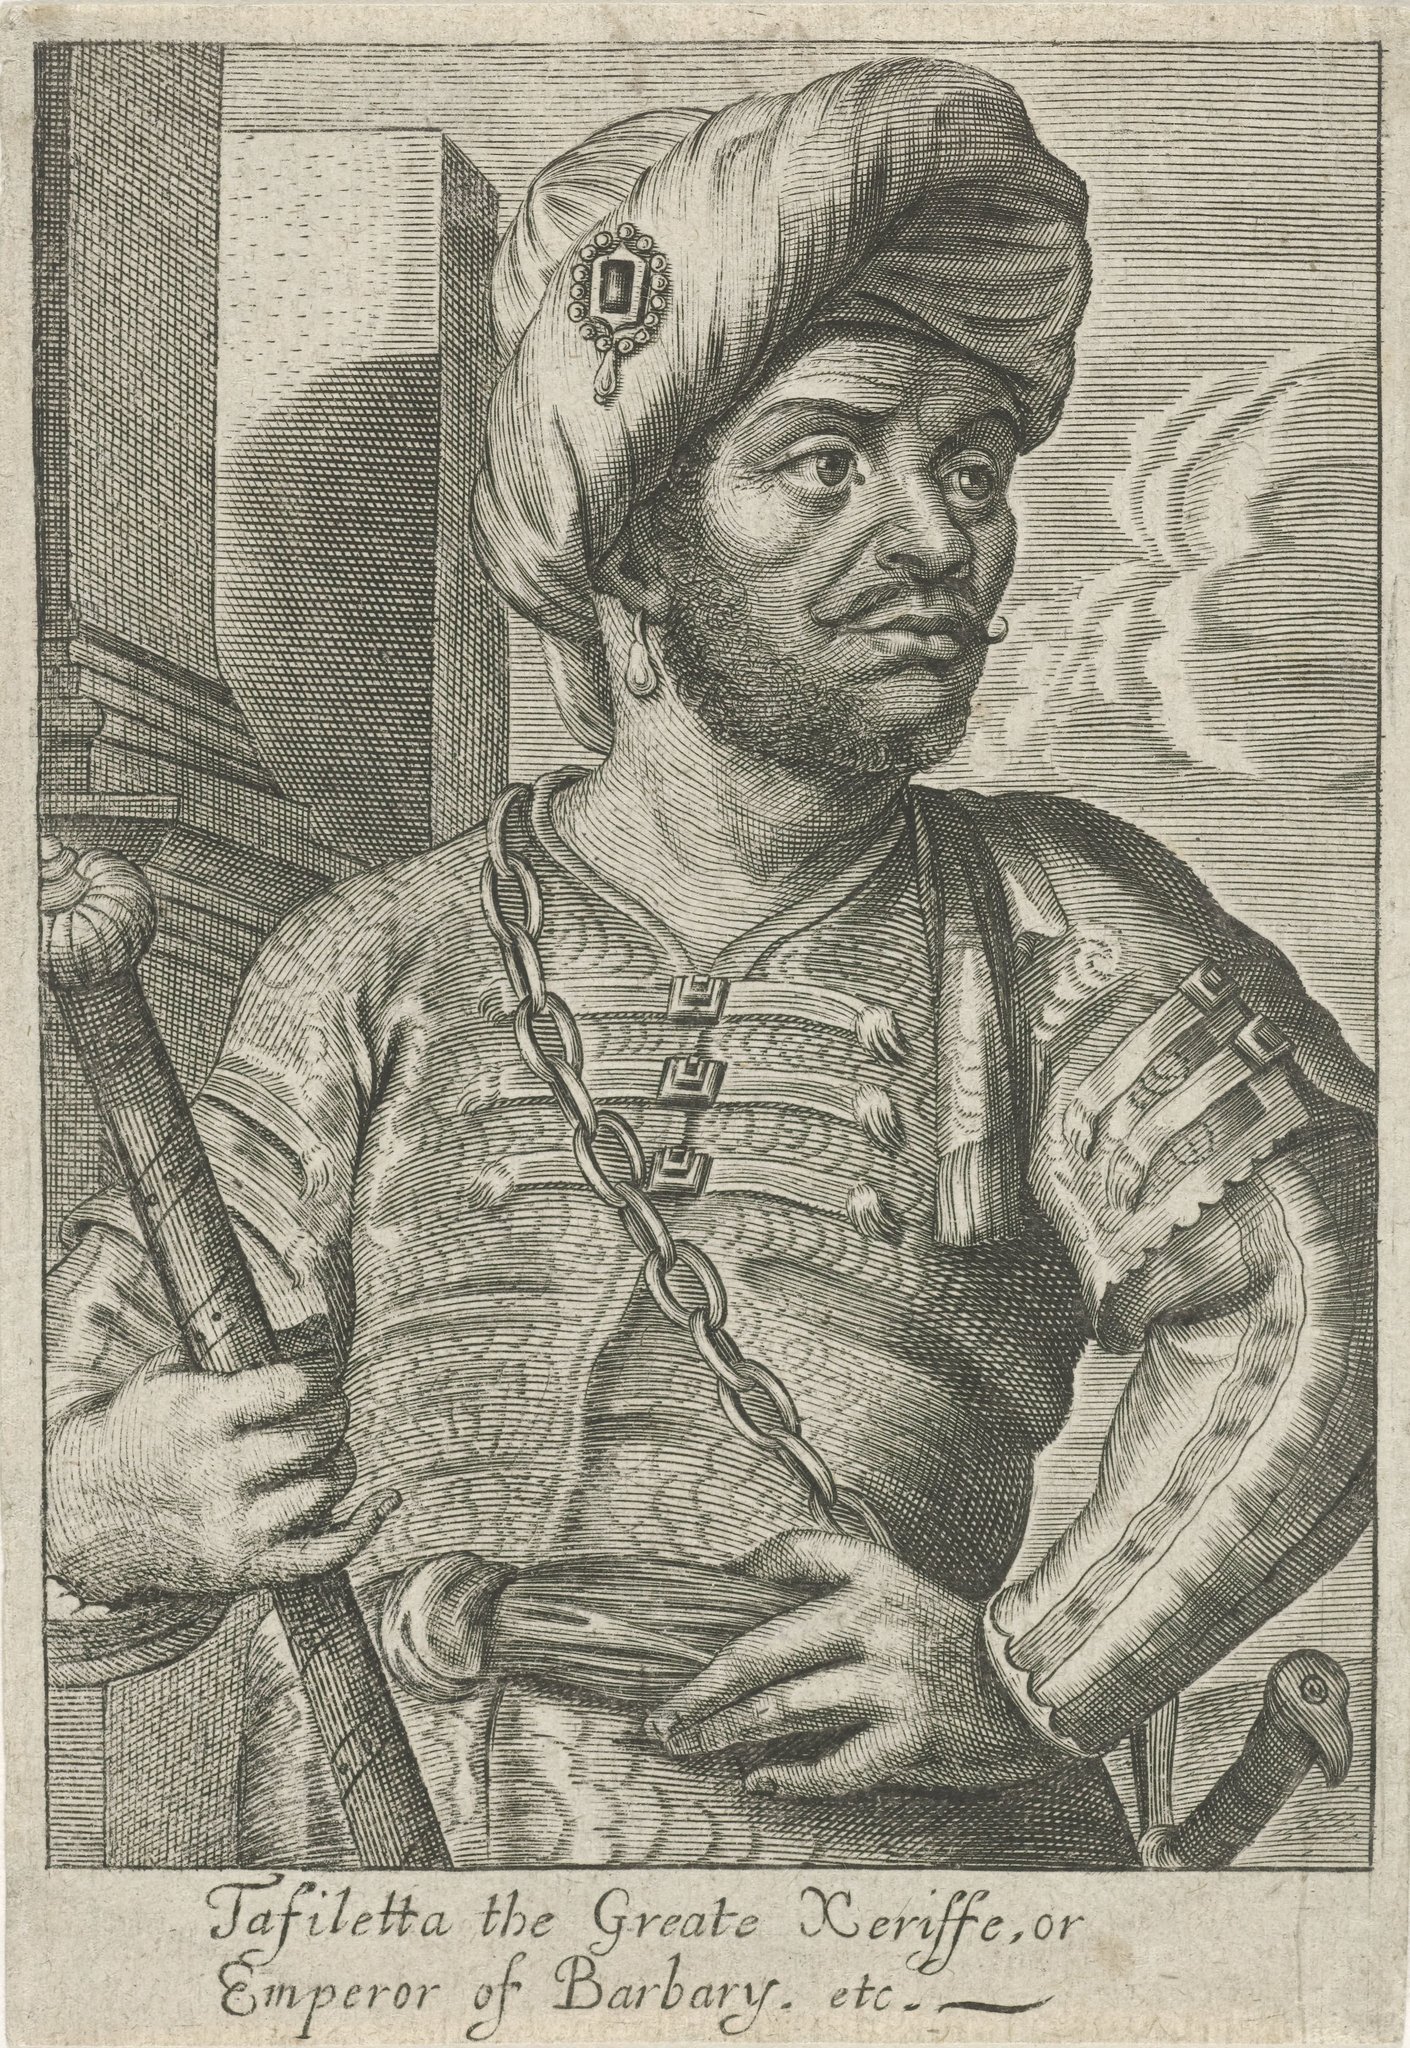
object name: print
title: Portret van Moulay al-Rashid, sultan van Marokko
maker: adriaen lommelin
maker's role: print maker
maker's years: 1618-1675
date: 1630-1677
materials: paper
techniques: engraving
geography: antwerp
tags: africans, king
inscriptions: collector's mark: Lugt 2228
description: Portret van Moulay al-Rashid, sultan van Marokko, met tulband op het hoofd en een scepter in de hand.